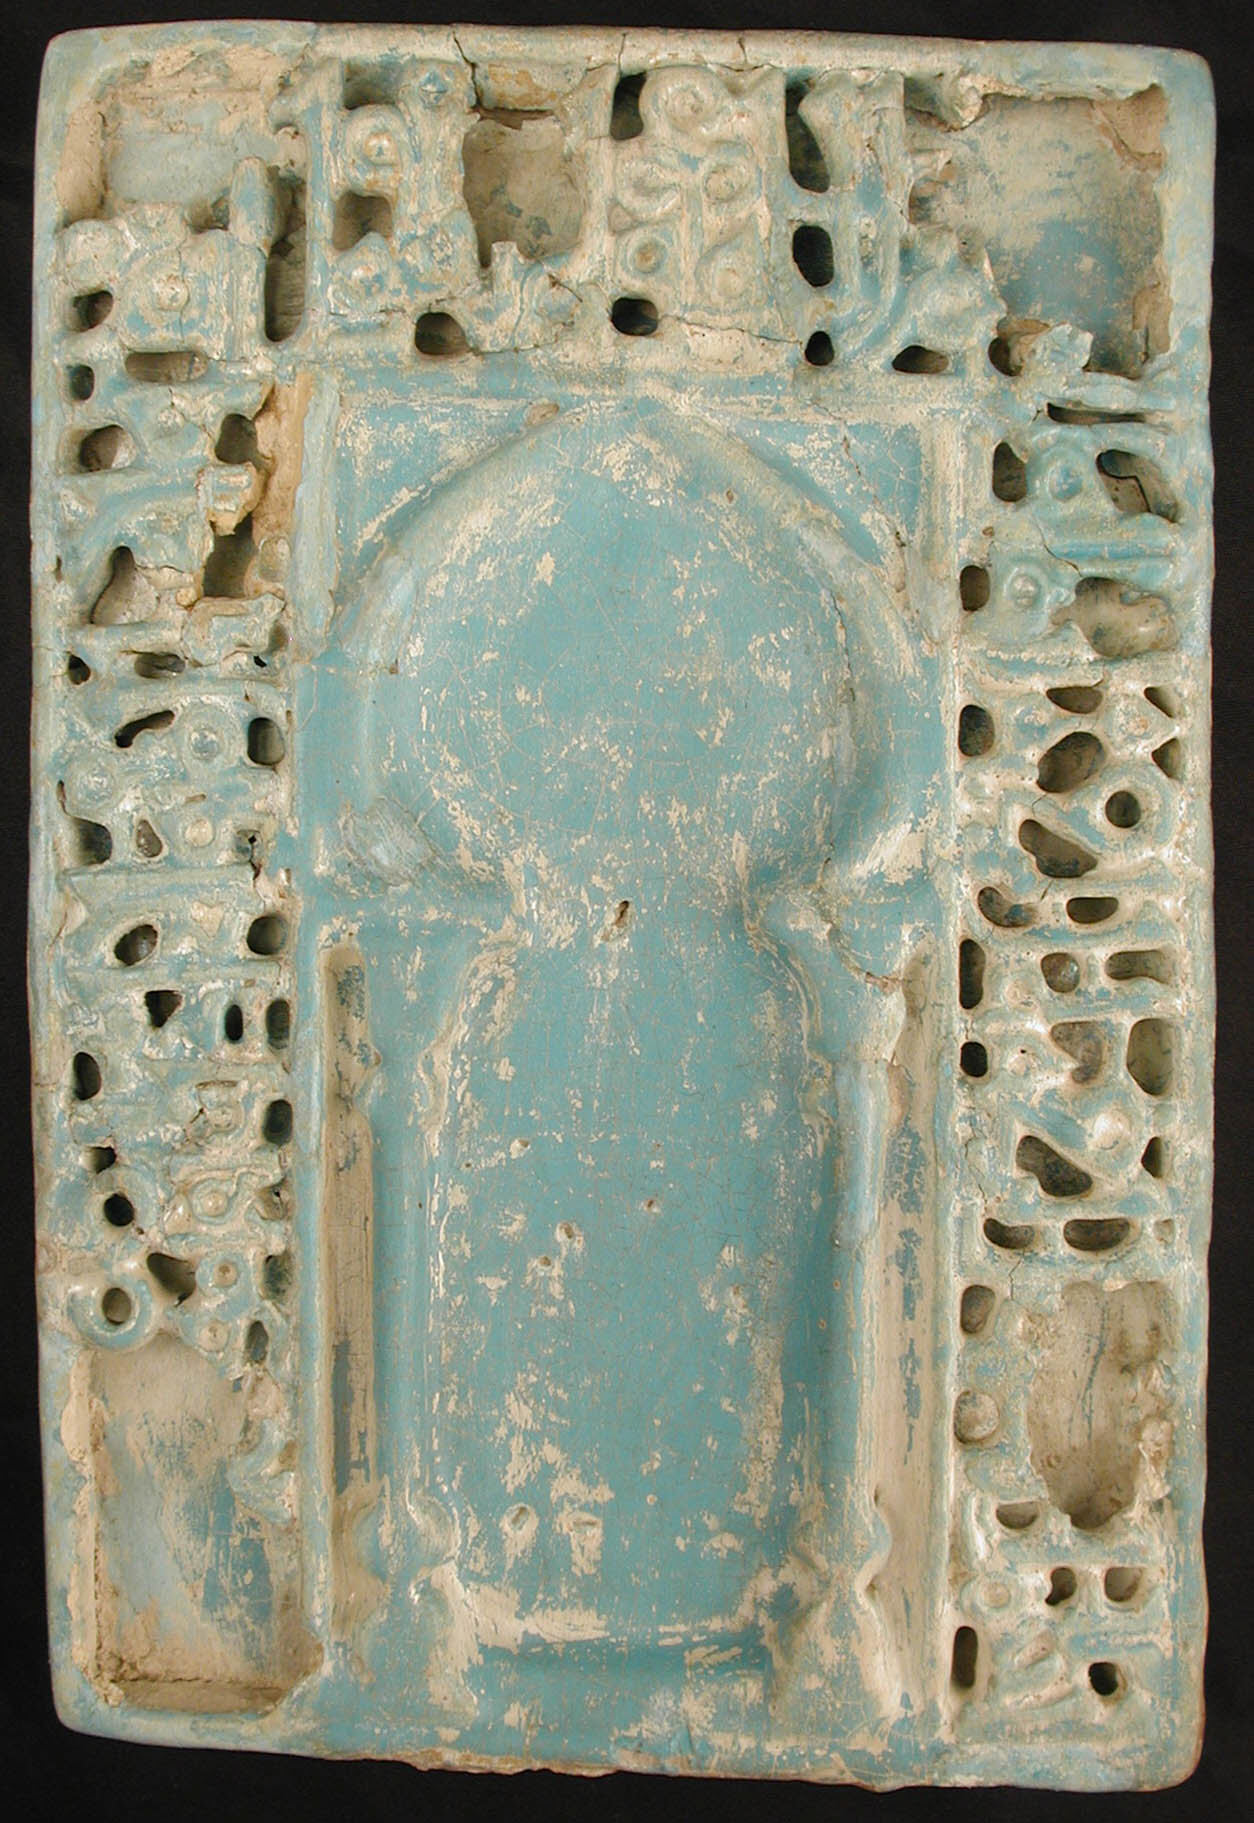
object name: tile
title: Tile with Niche Design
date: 1101-1200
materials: stonepaste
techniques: carving, glazing, molding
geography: iran